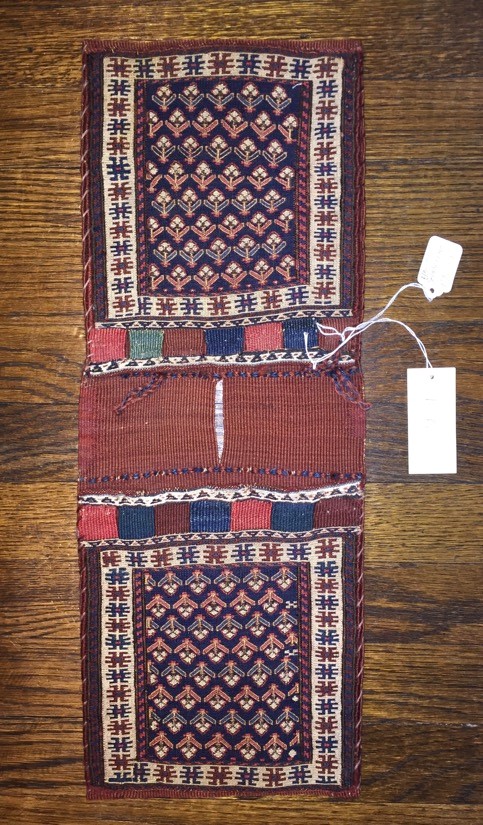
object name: saddle bag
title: Shahsevan Double Saddle Bag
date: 1880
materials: cotton, wool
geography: iran